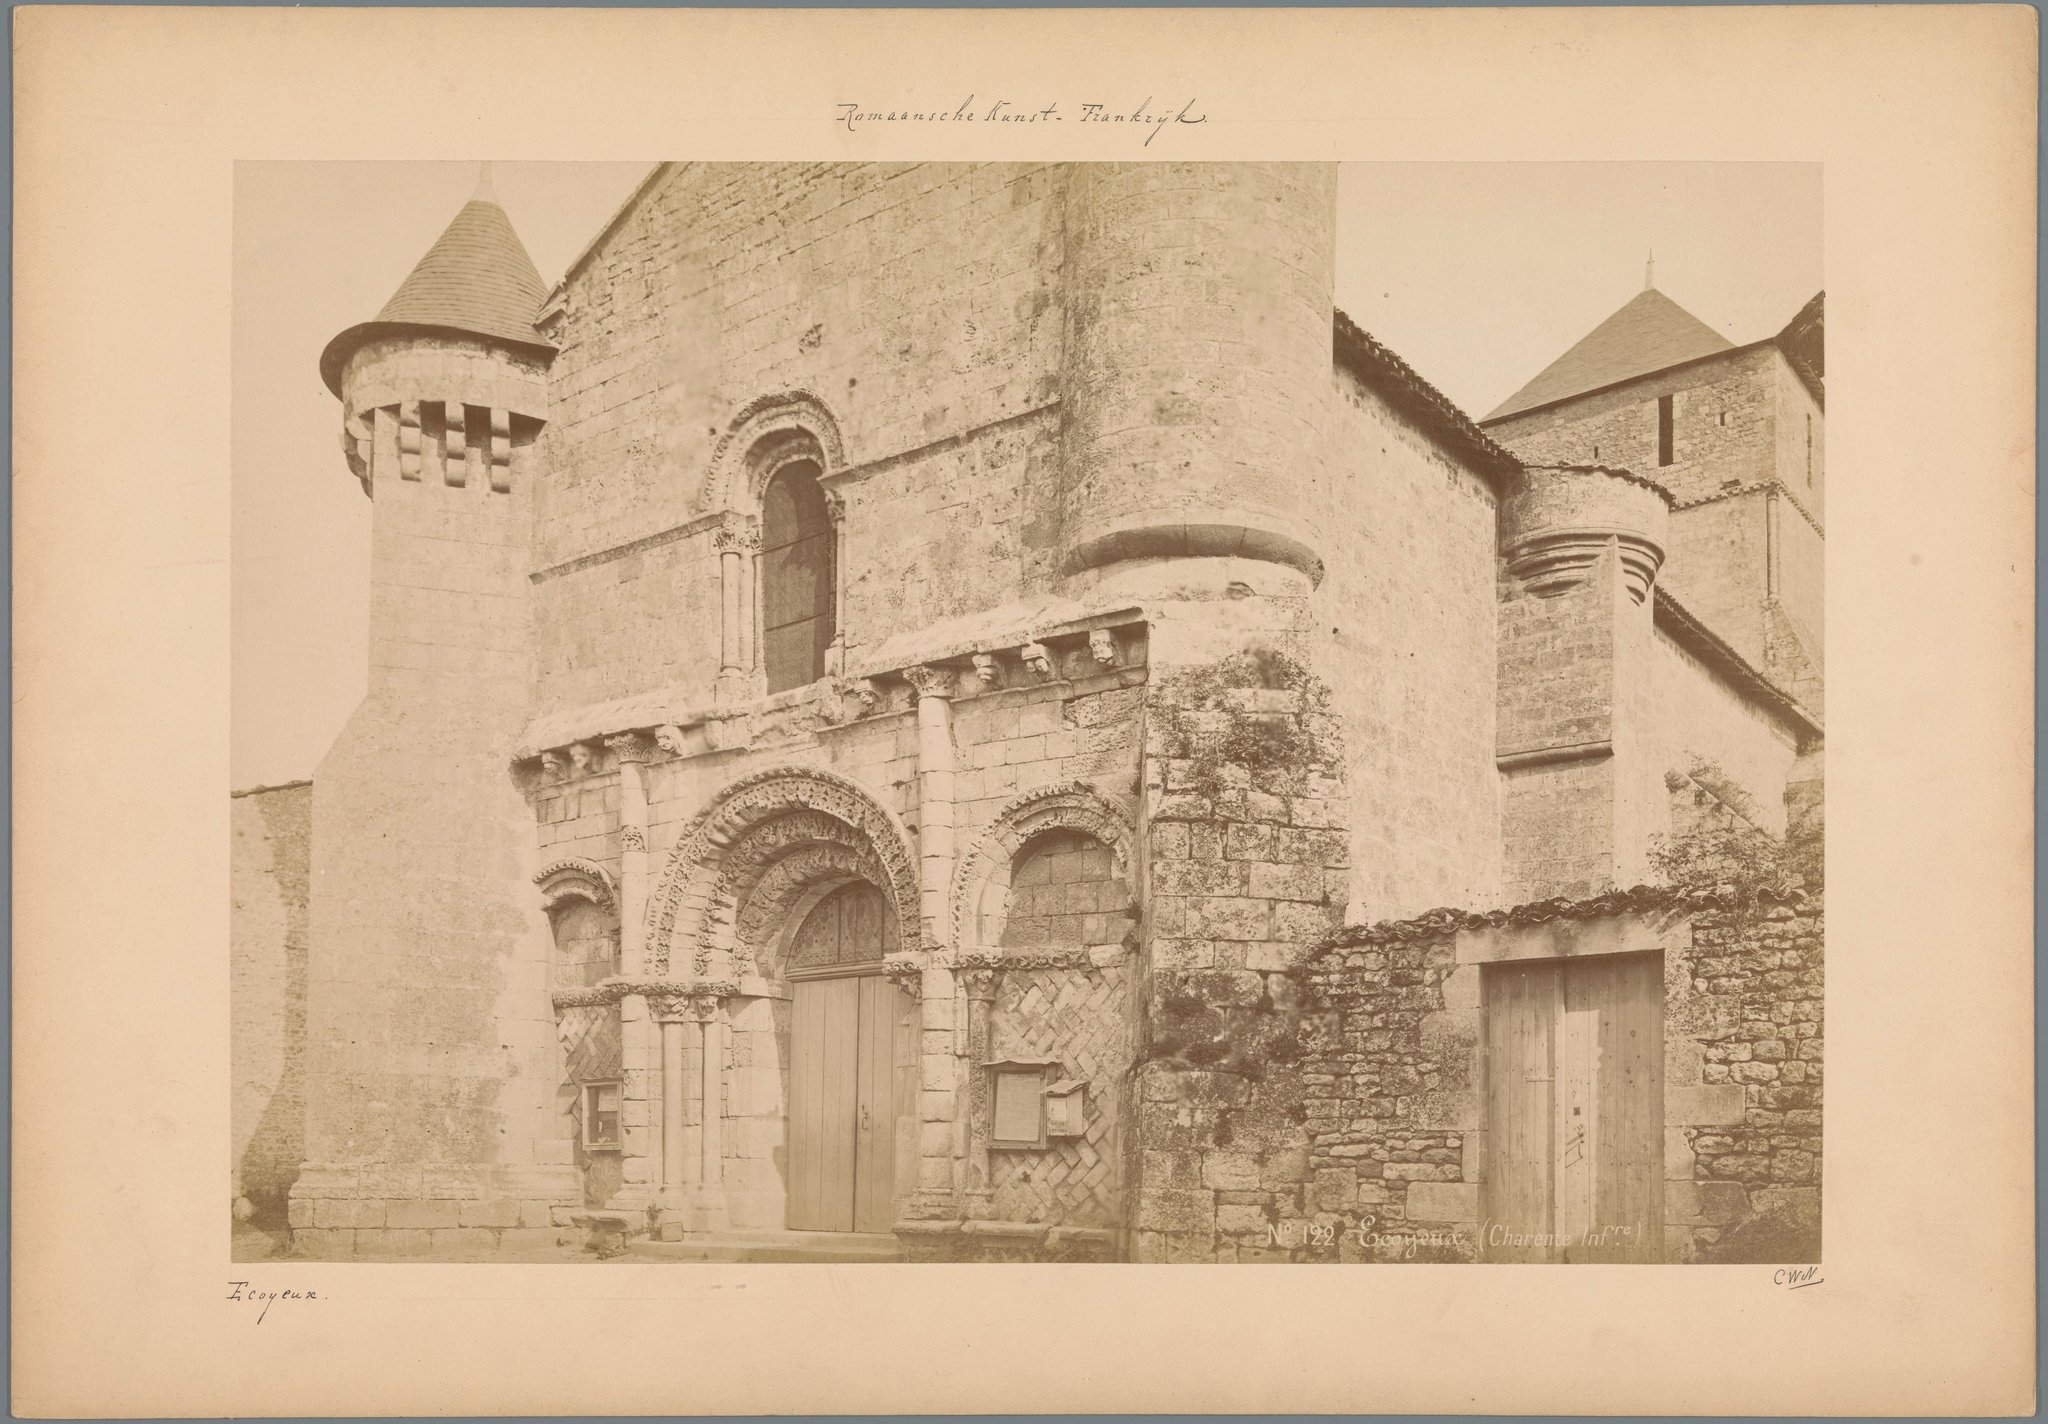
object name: photograph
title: Ecoyeux (Charente Infre.)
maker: séraphin-médéric mieusement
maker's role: fotograaf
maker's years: 1840-1905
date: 1875-1900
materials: cardboard, photographic support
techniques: albumen print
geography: ecoyeux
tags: parts of church exterior and annexes: portal, church (exterior), façade (of house or building)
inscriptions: inscription: ‘MONUMENTS HISTORIQUES’, inscription: ‘Romaansche Kunst - Frankrijk. Ecoyeux.’, inscription: ‘CWN.’, number: ‘No. 122’, collector's mark: ‘INSTITUUT VOOR KUNST- NIJVERHEIDSONDERWIJS GABRIËL METSUSTRAAT No. 16. AMSTERDAM’, collector's mark: ‘KUNSTNIJVERHEIDSCHOOL QUELLINUS AMSTERDAM FRANS HALSSTRAAT 14.’, name: ‘MIEUSEMENT PHOTOGRAPHE’